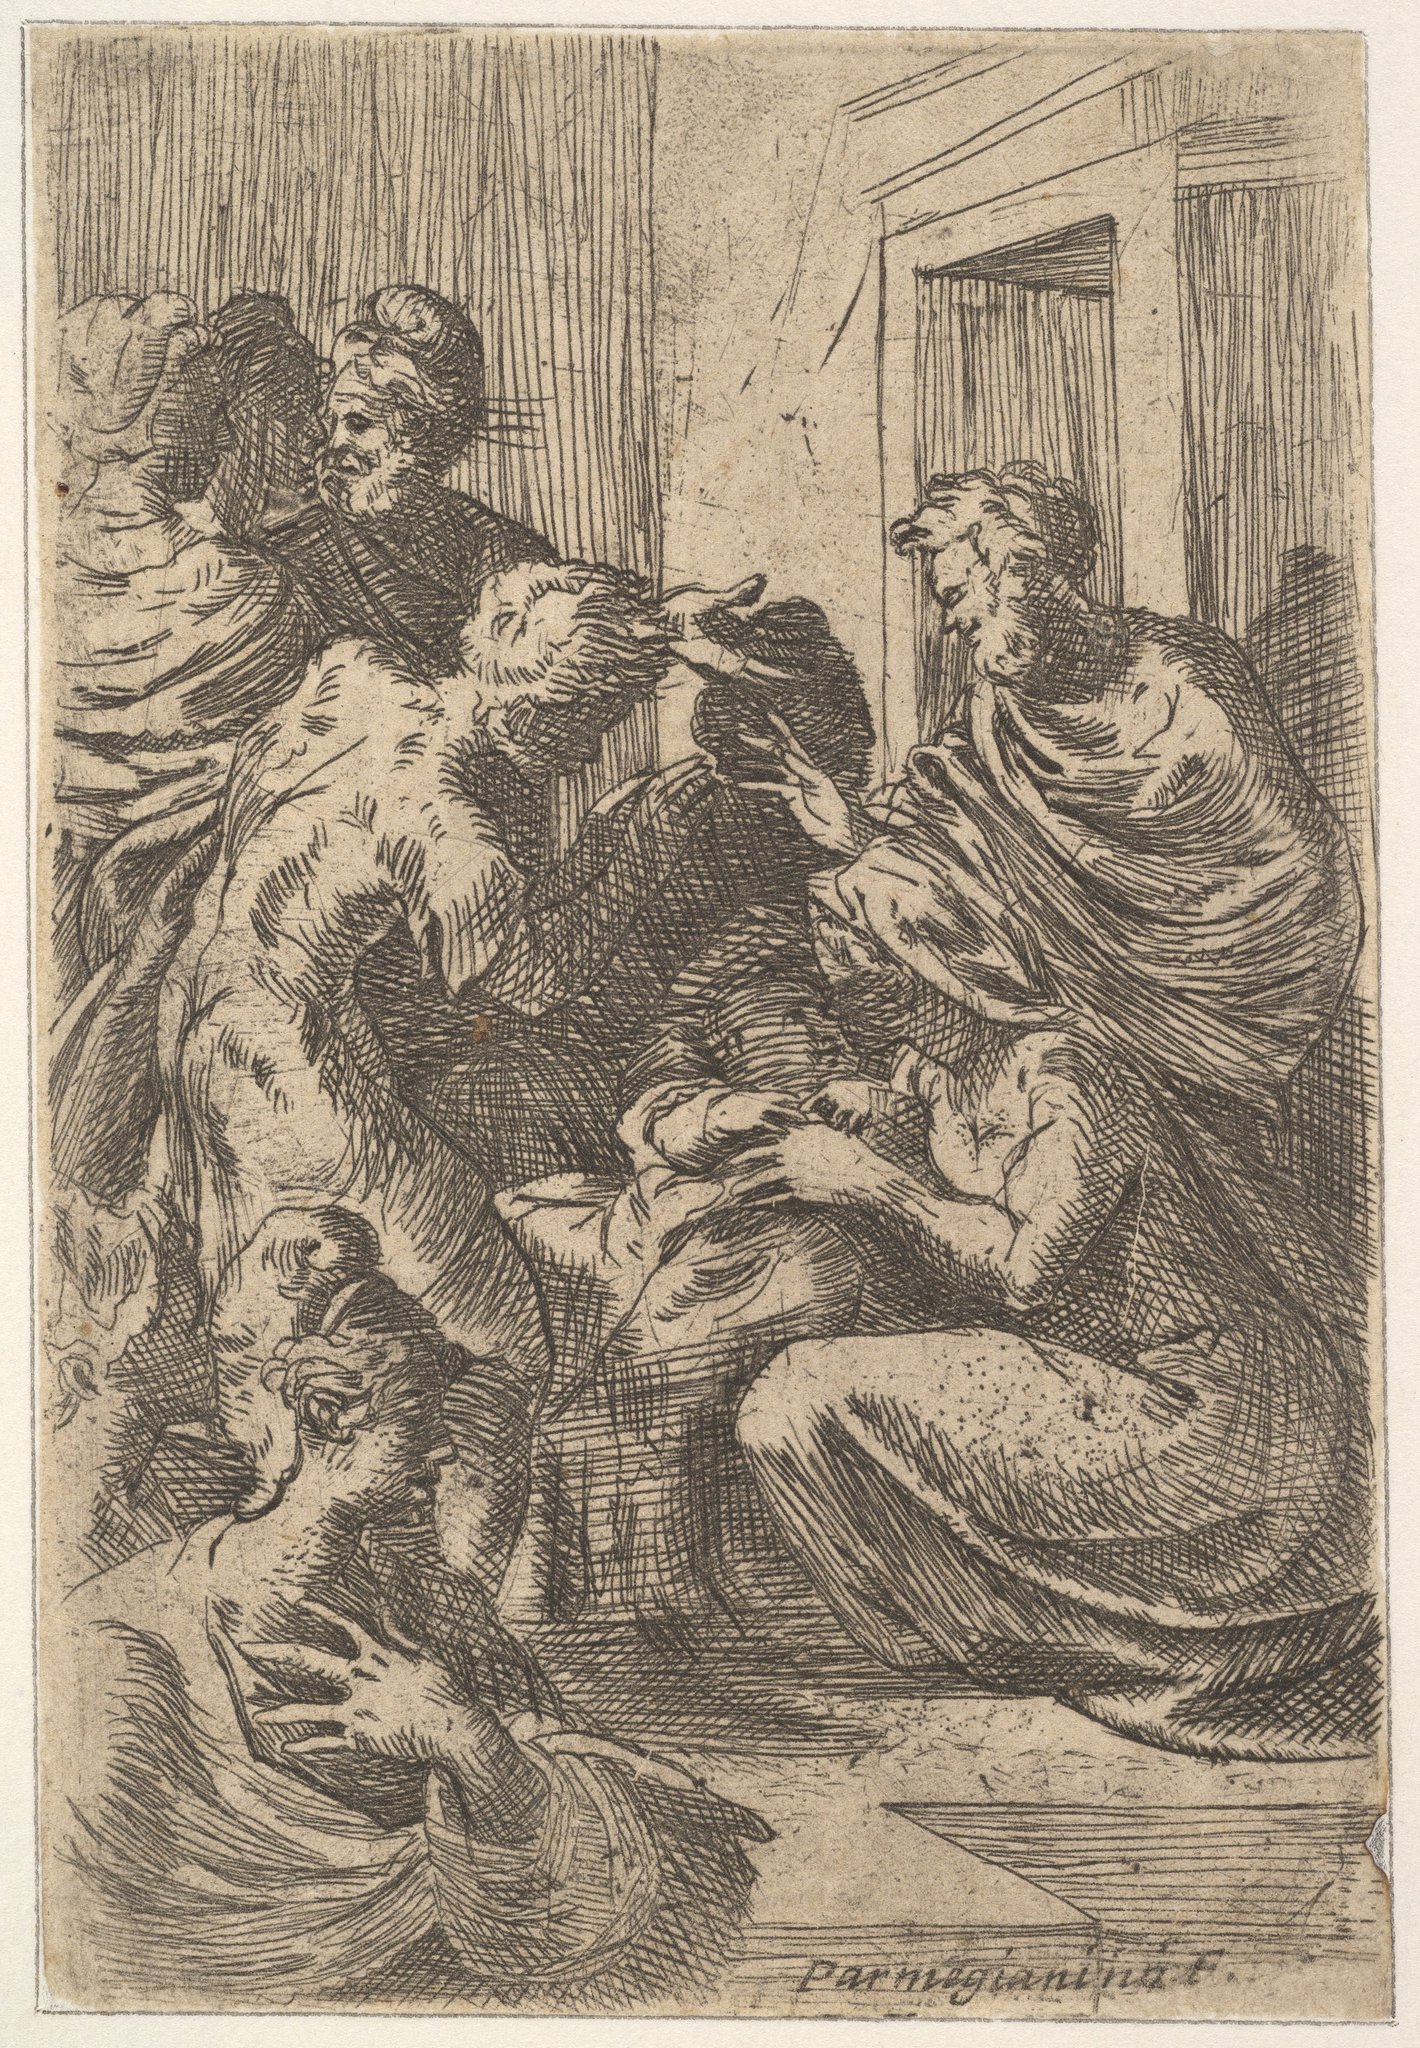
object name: print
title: Nativity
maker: anonymous, italian, 17th century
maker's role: artist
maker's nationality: italian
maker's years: 1600-1700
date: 1601-1700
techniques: etching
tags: men,women,nativity